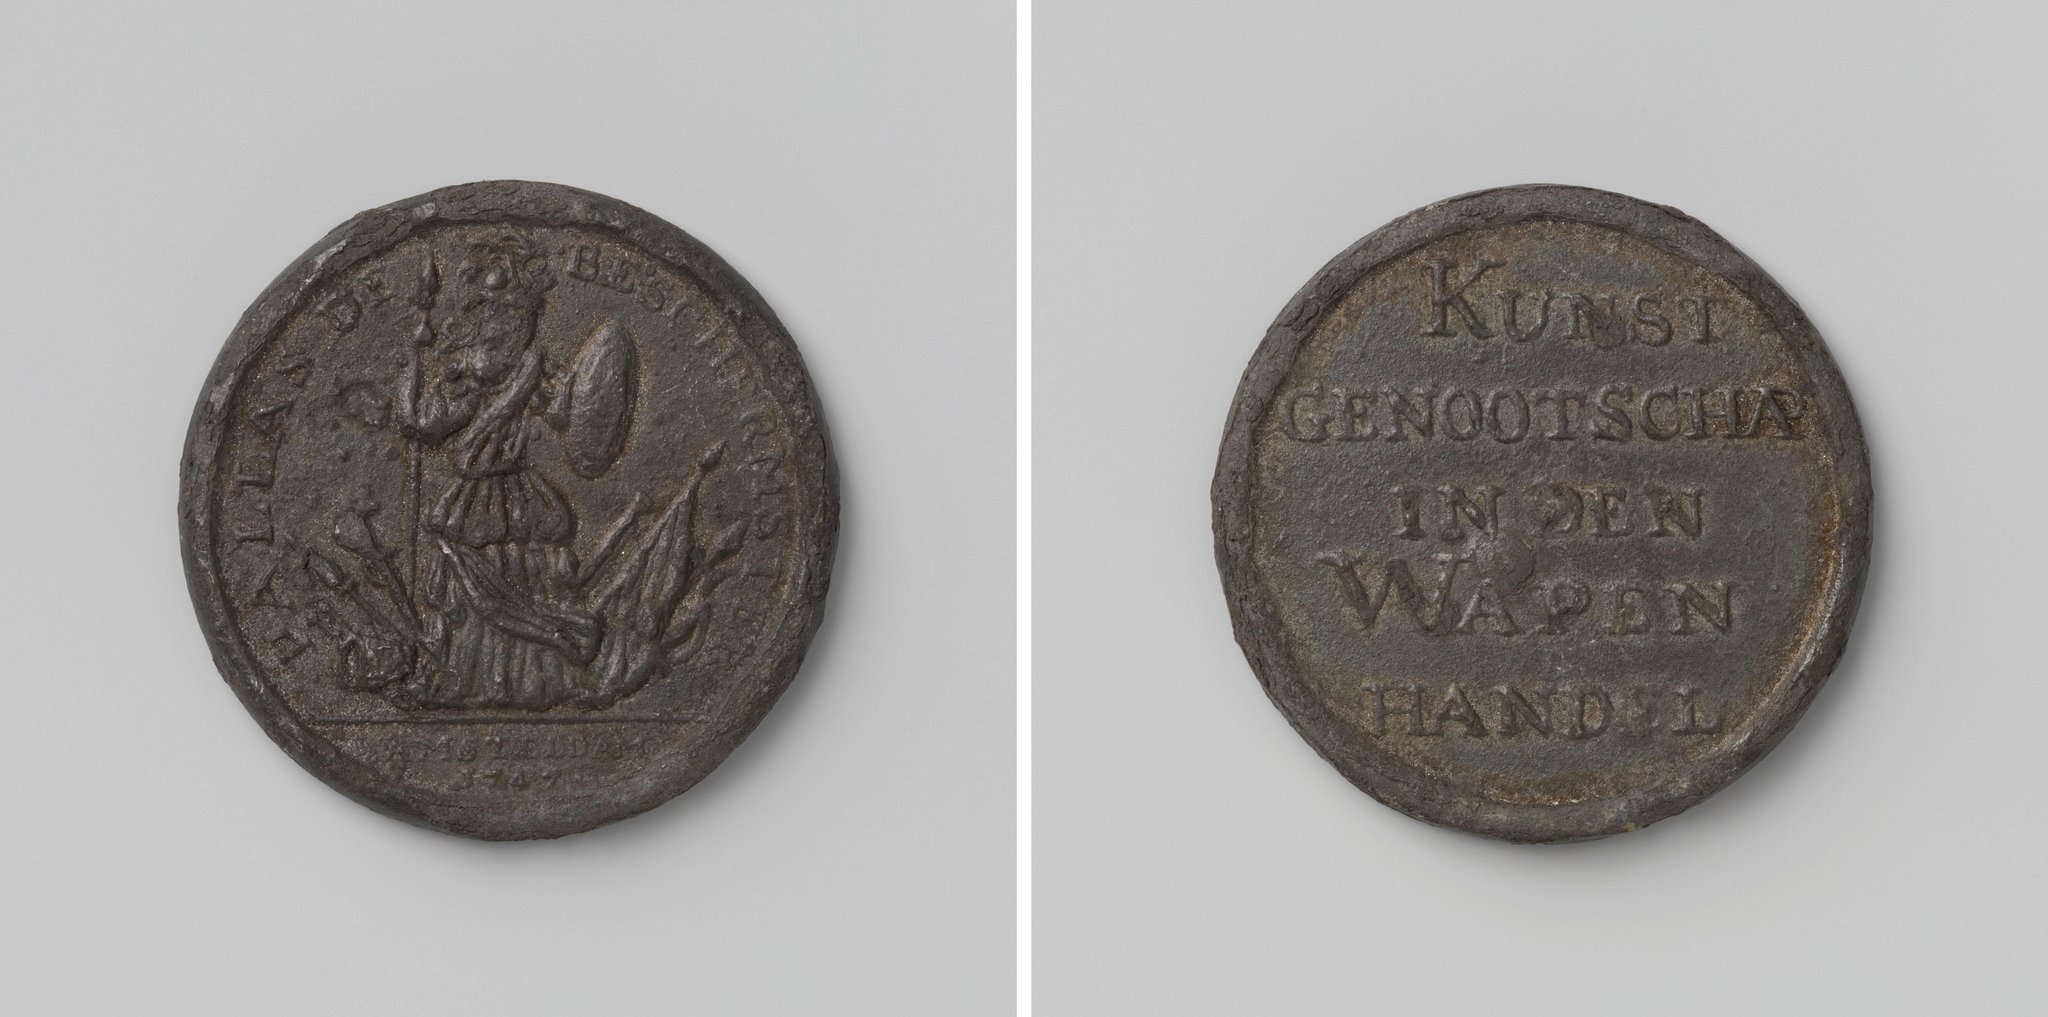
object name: marksman medal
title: Kunstgenootschap in den wapenhandel te Amsterdam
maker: Anonymous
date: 1747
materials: lead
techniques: striking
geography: amsterdam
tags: amsterdam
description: Loden penning. Voorzijde: Minerva met gepluimde helm, schild en speer, voostellende de stad Amsterdam, staande temidden van stapel wapentuig binnen omschrift; afsnede: opschrift en jaartal. Keerzijde: opschrift.